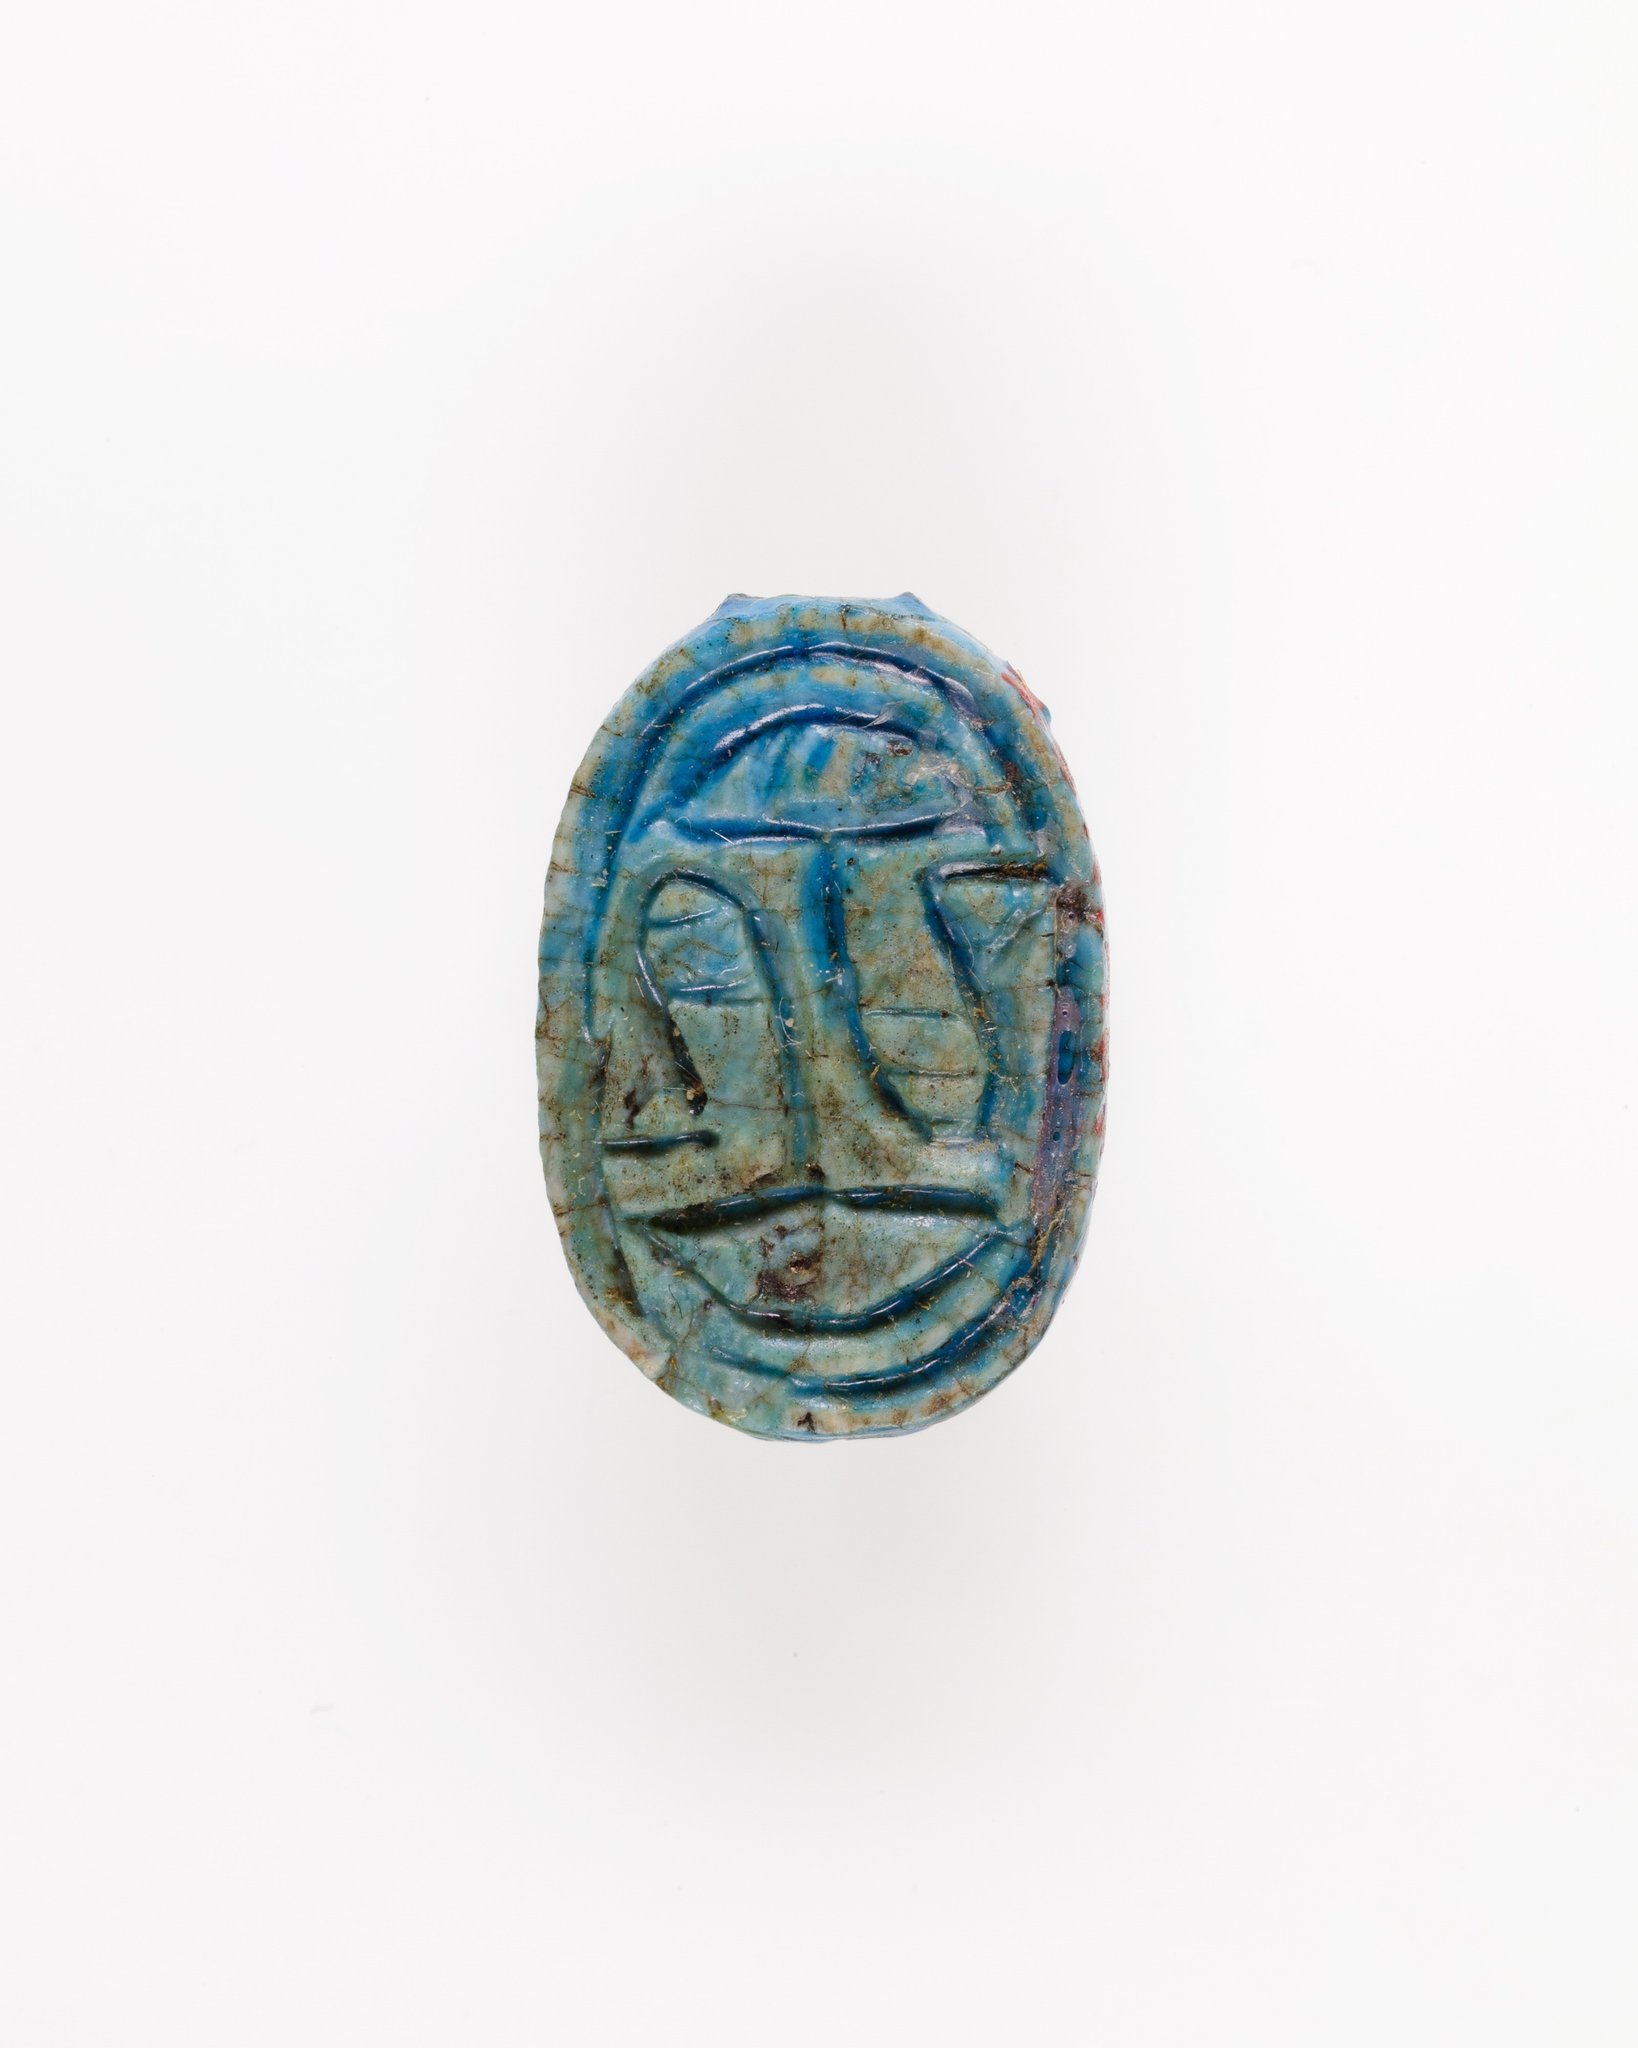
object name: scarab, papyrus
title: Scarab with Papyrus Motif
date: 1850-1640 BCE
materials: faience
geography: egypt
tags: scarabs